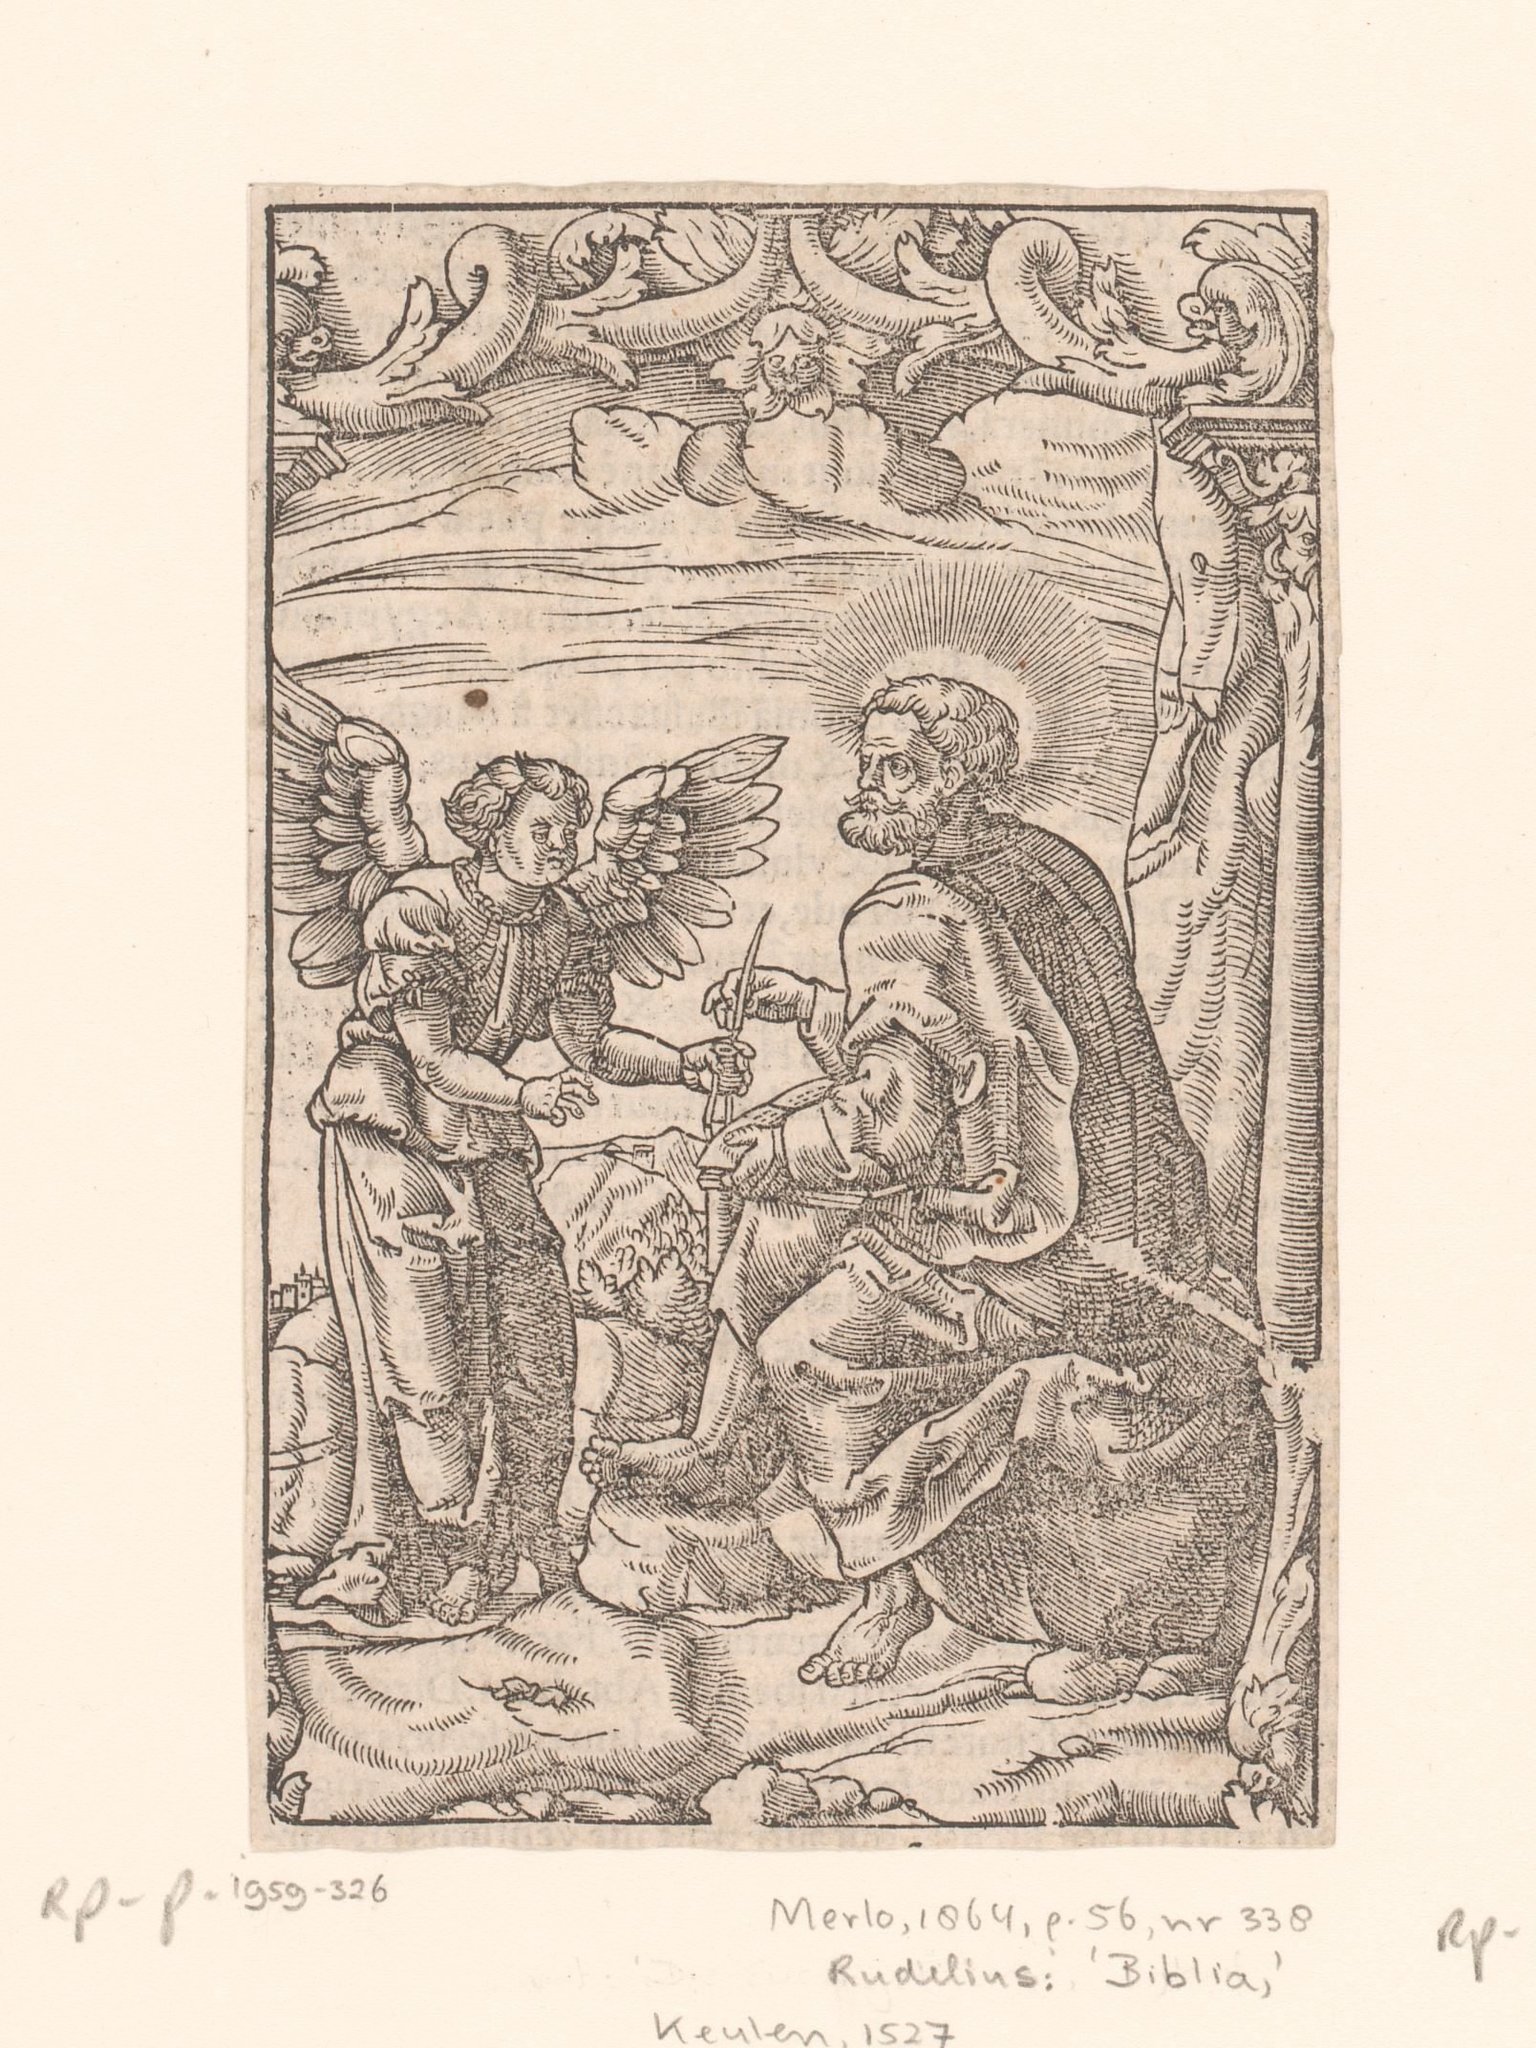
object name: print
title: Evangelist Mattheüs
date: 1527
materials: paper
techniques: woodcut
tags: the apostle and evangelist matthew (mattheus); possible attributes: angel, axe, book, halberd, pen and inkhorn, purse, scroll, square, sword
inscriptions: collector's mark: Lugt 2228, collector's mark: Lugt 2760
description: Prent gebruikt in: Biblia sacra utriusque testamenti. Keulen: Peter Quentel, 1527.